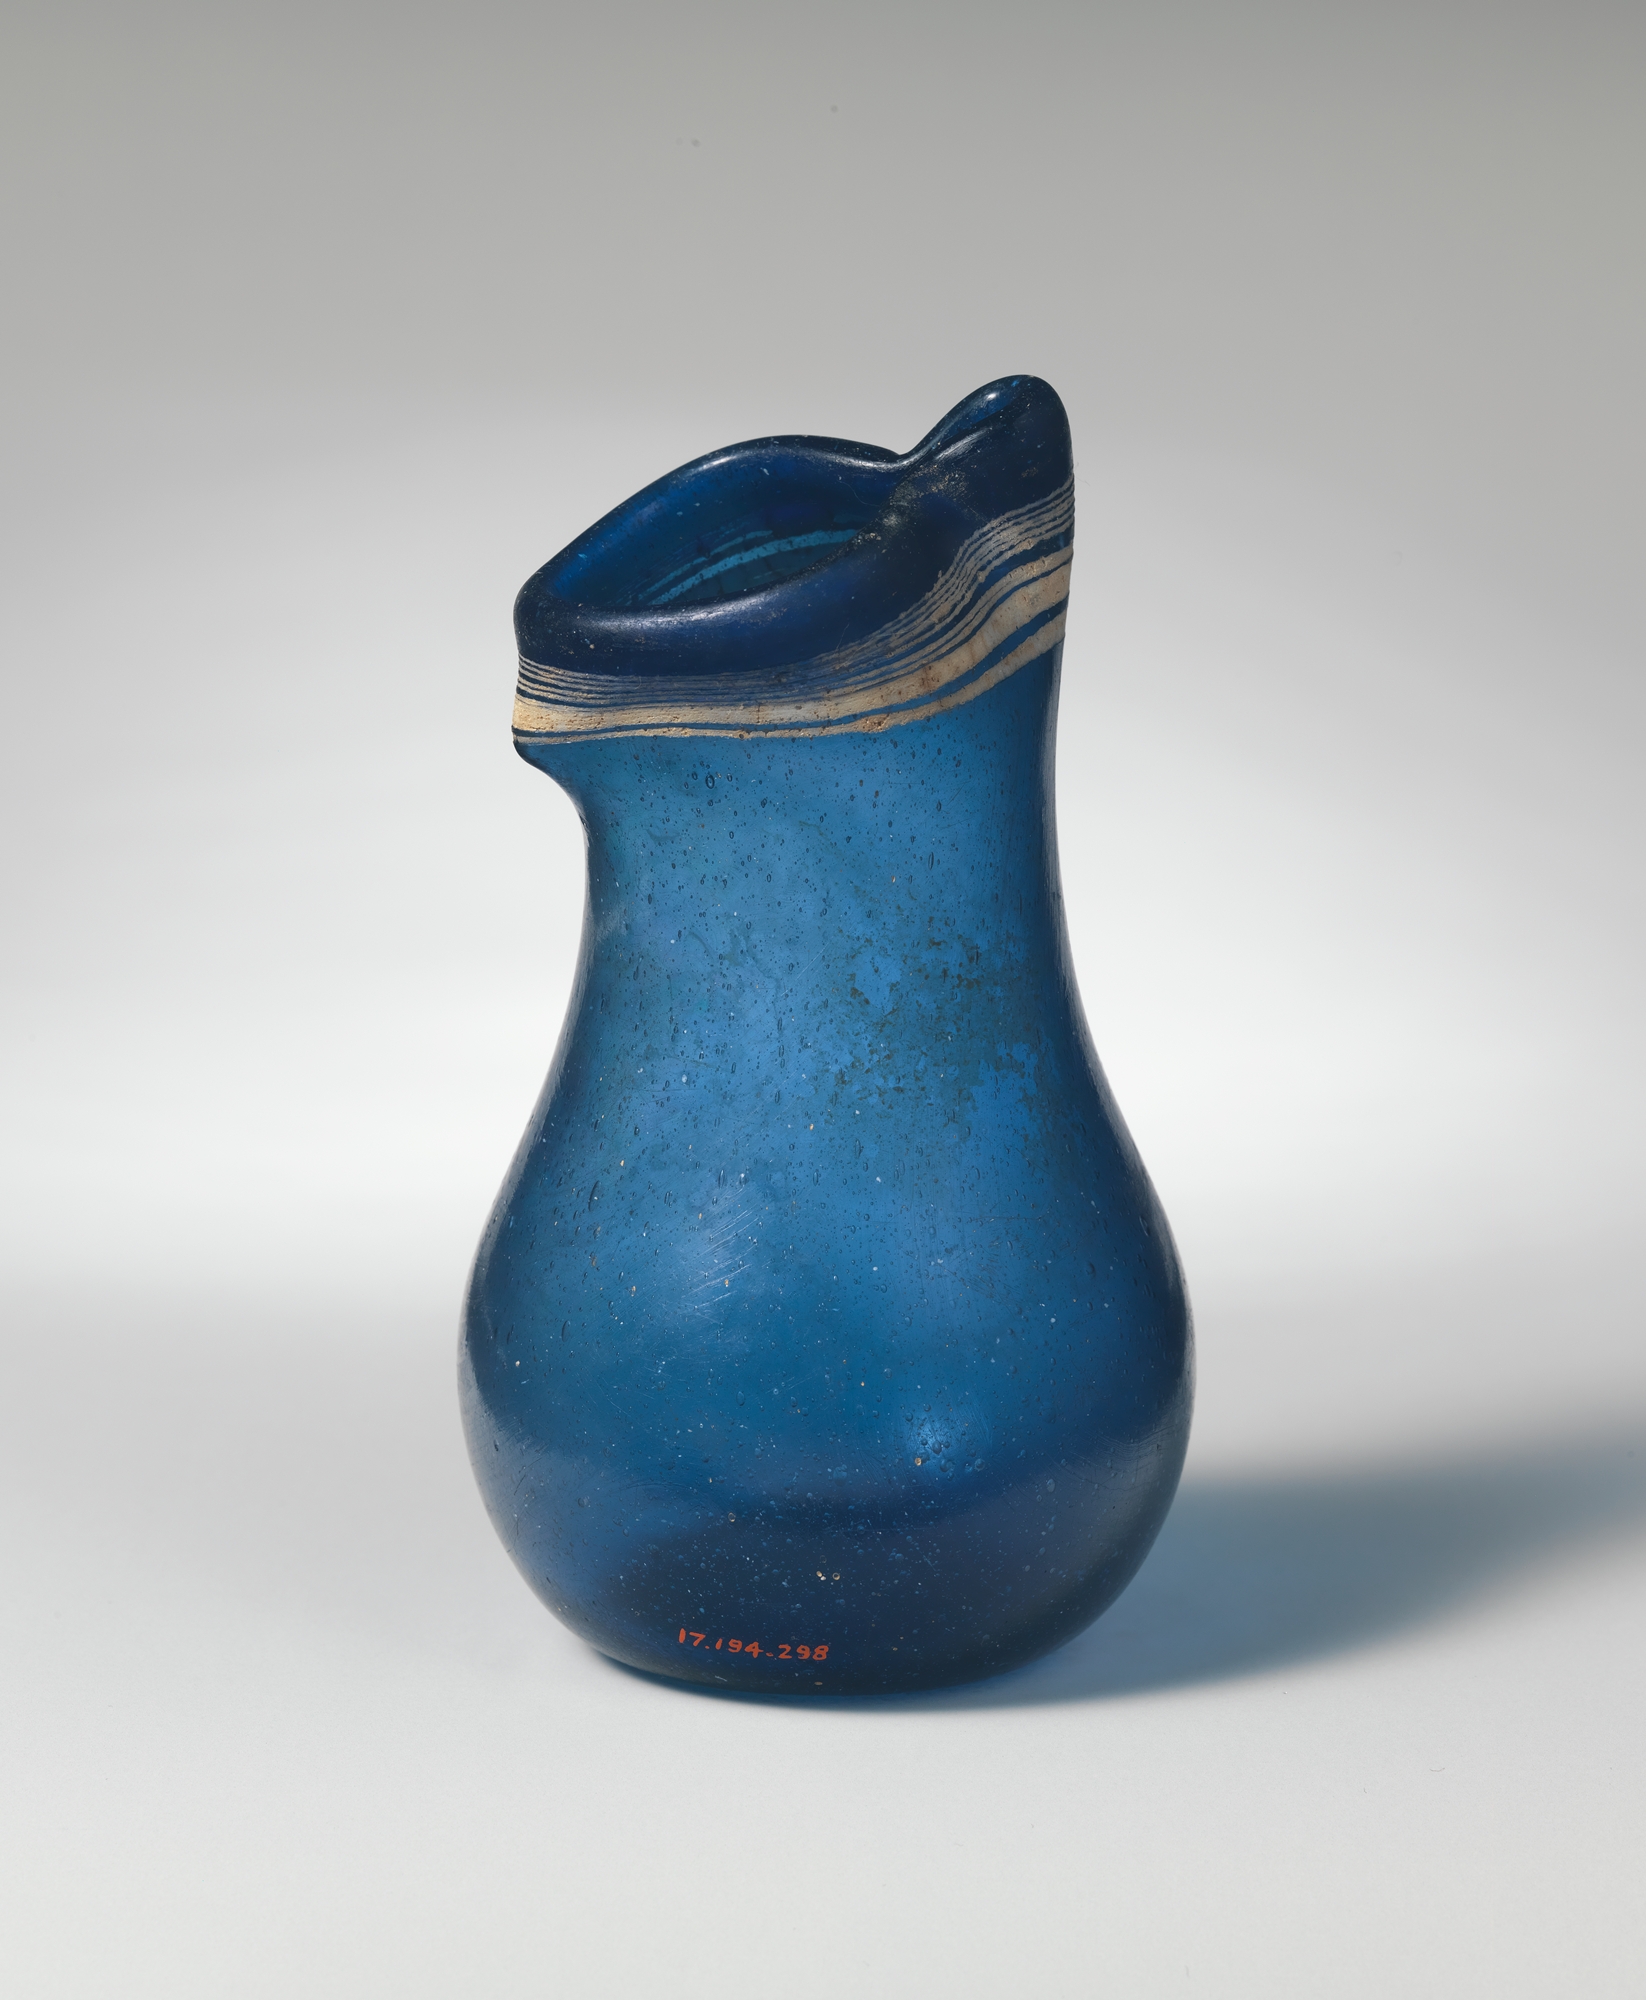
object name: jar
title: Glass jar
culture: roman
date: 301-600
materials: glass